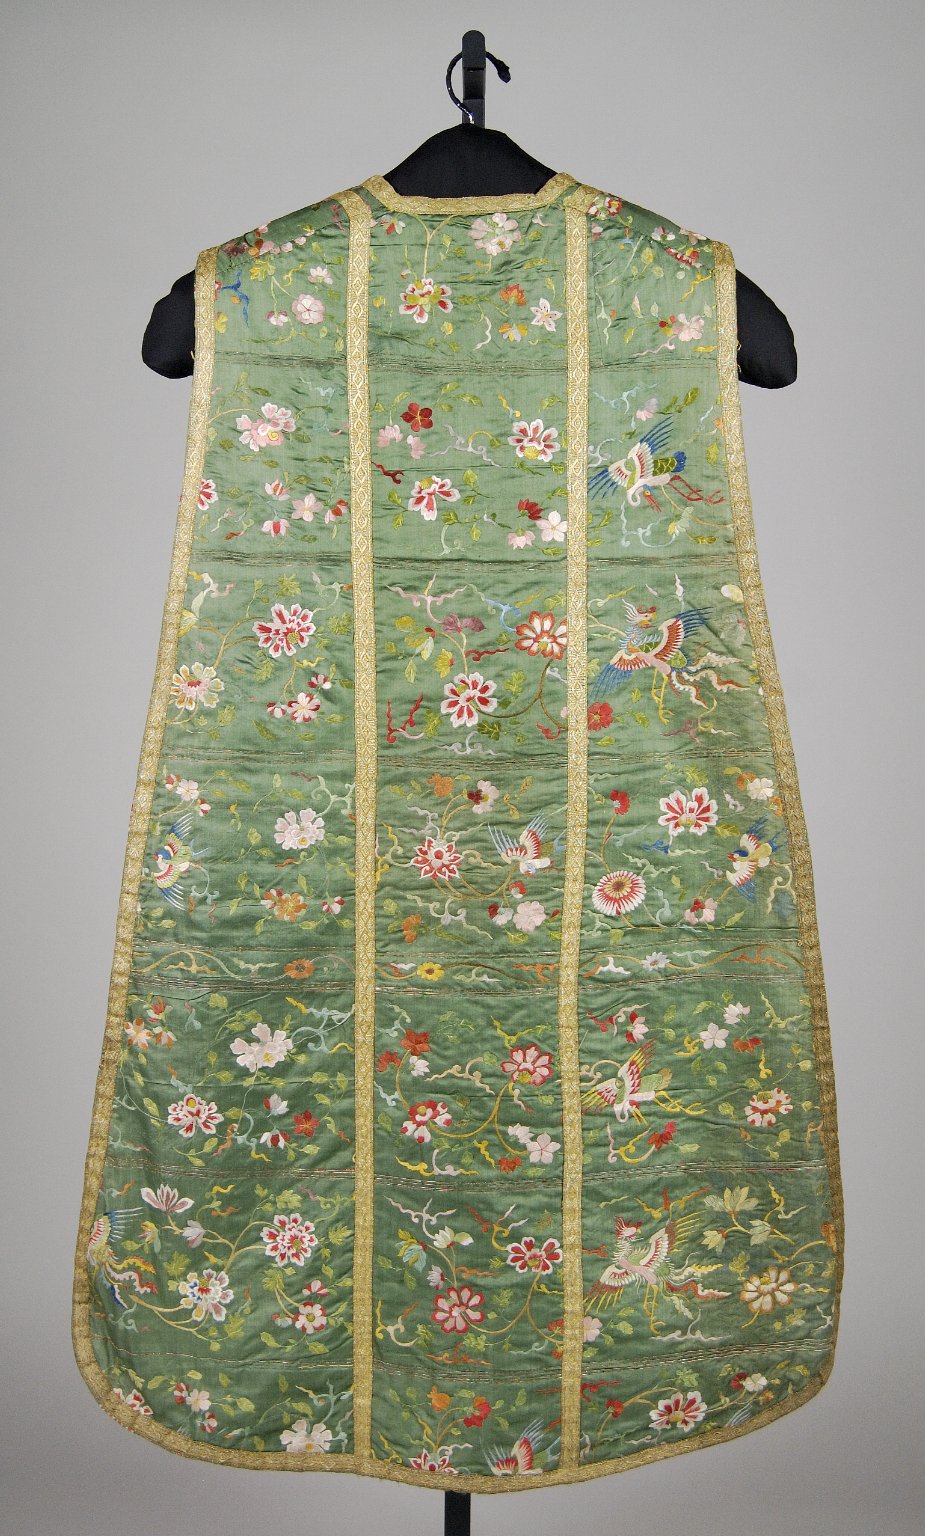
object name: chasuble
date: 1890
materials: silk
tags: flowers